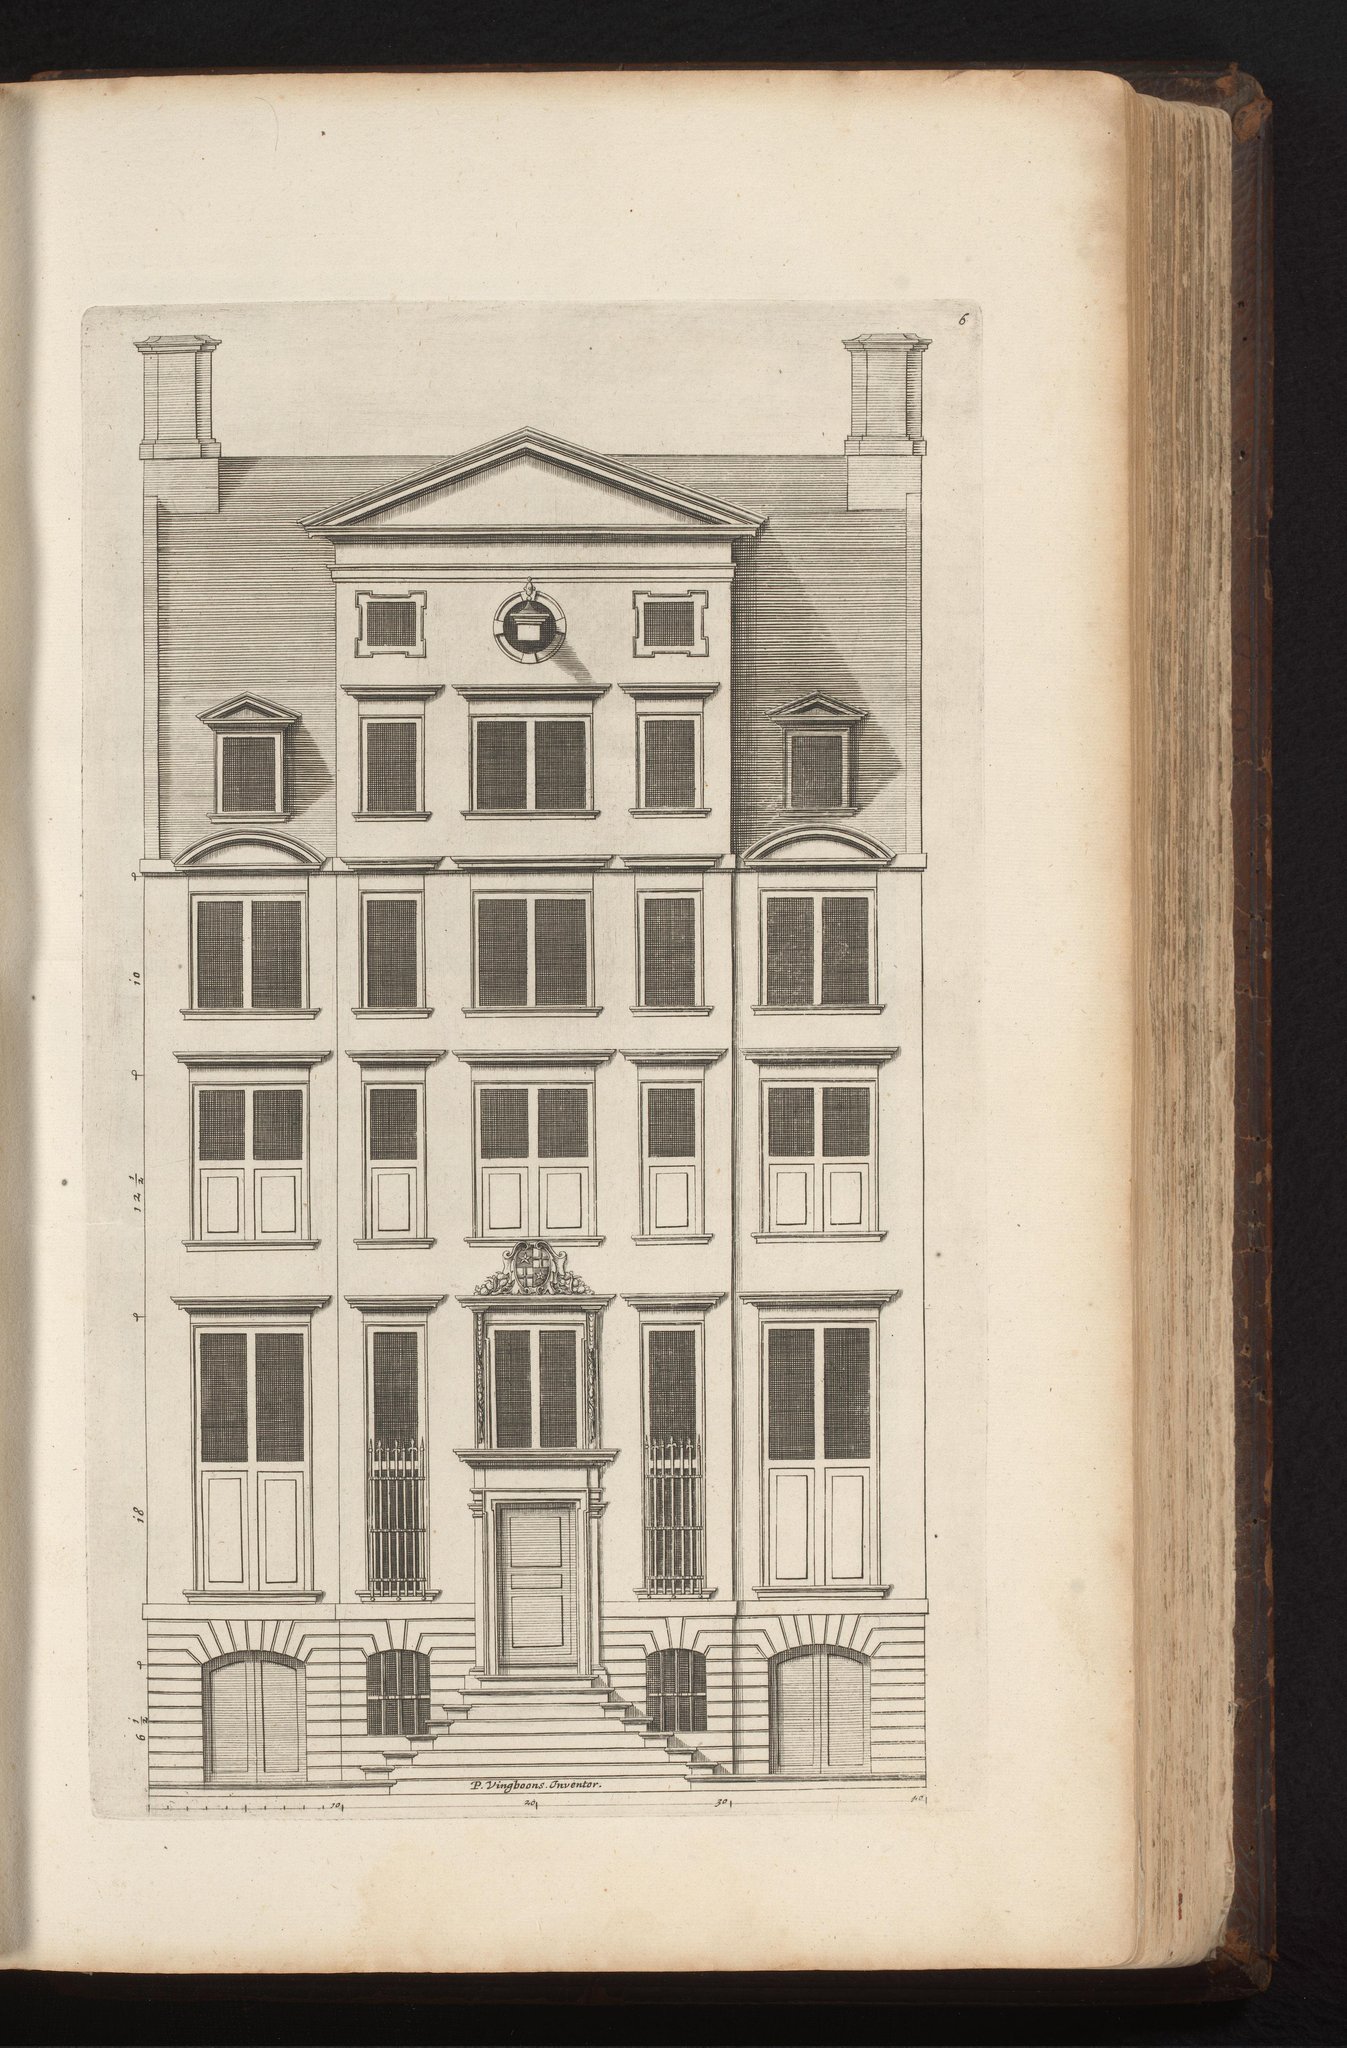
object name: book illustration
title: Gevel van een herenhuis aan de Herengracht te Amsterdam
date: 1648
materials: paper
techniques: engraving, etching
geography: amsterdam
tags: urban housing, armorial bearing, heraldry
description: Prent uit: Afbeelsels der voornaemste gebouwen uyt alle die Philips Vingboons geordineert heeft. Amsterdam: Philips en Johannes Vinckboons en Johannes Willemszoon Blaeu, 1648.